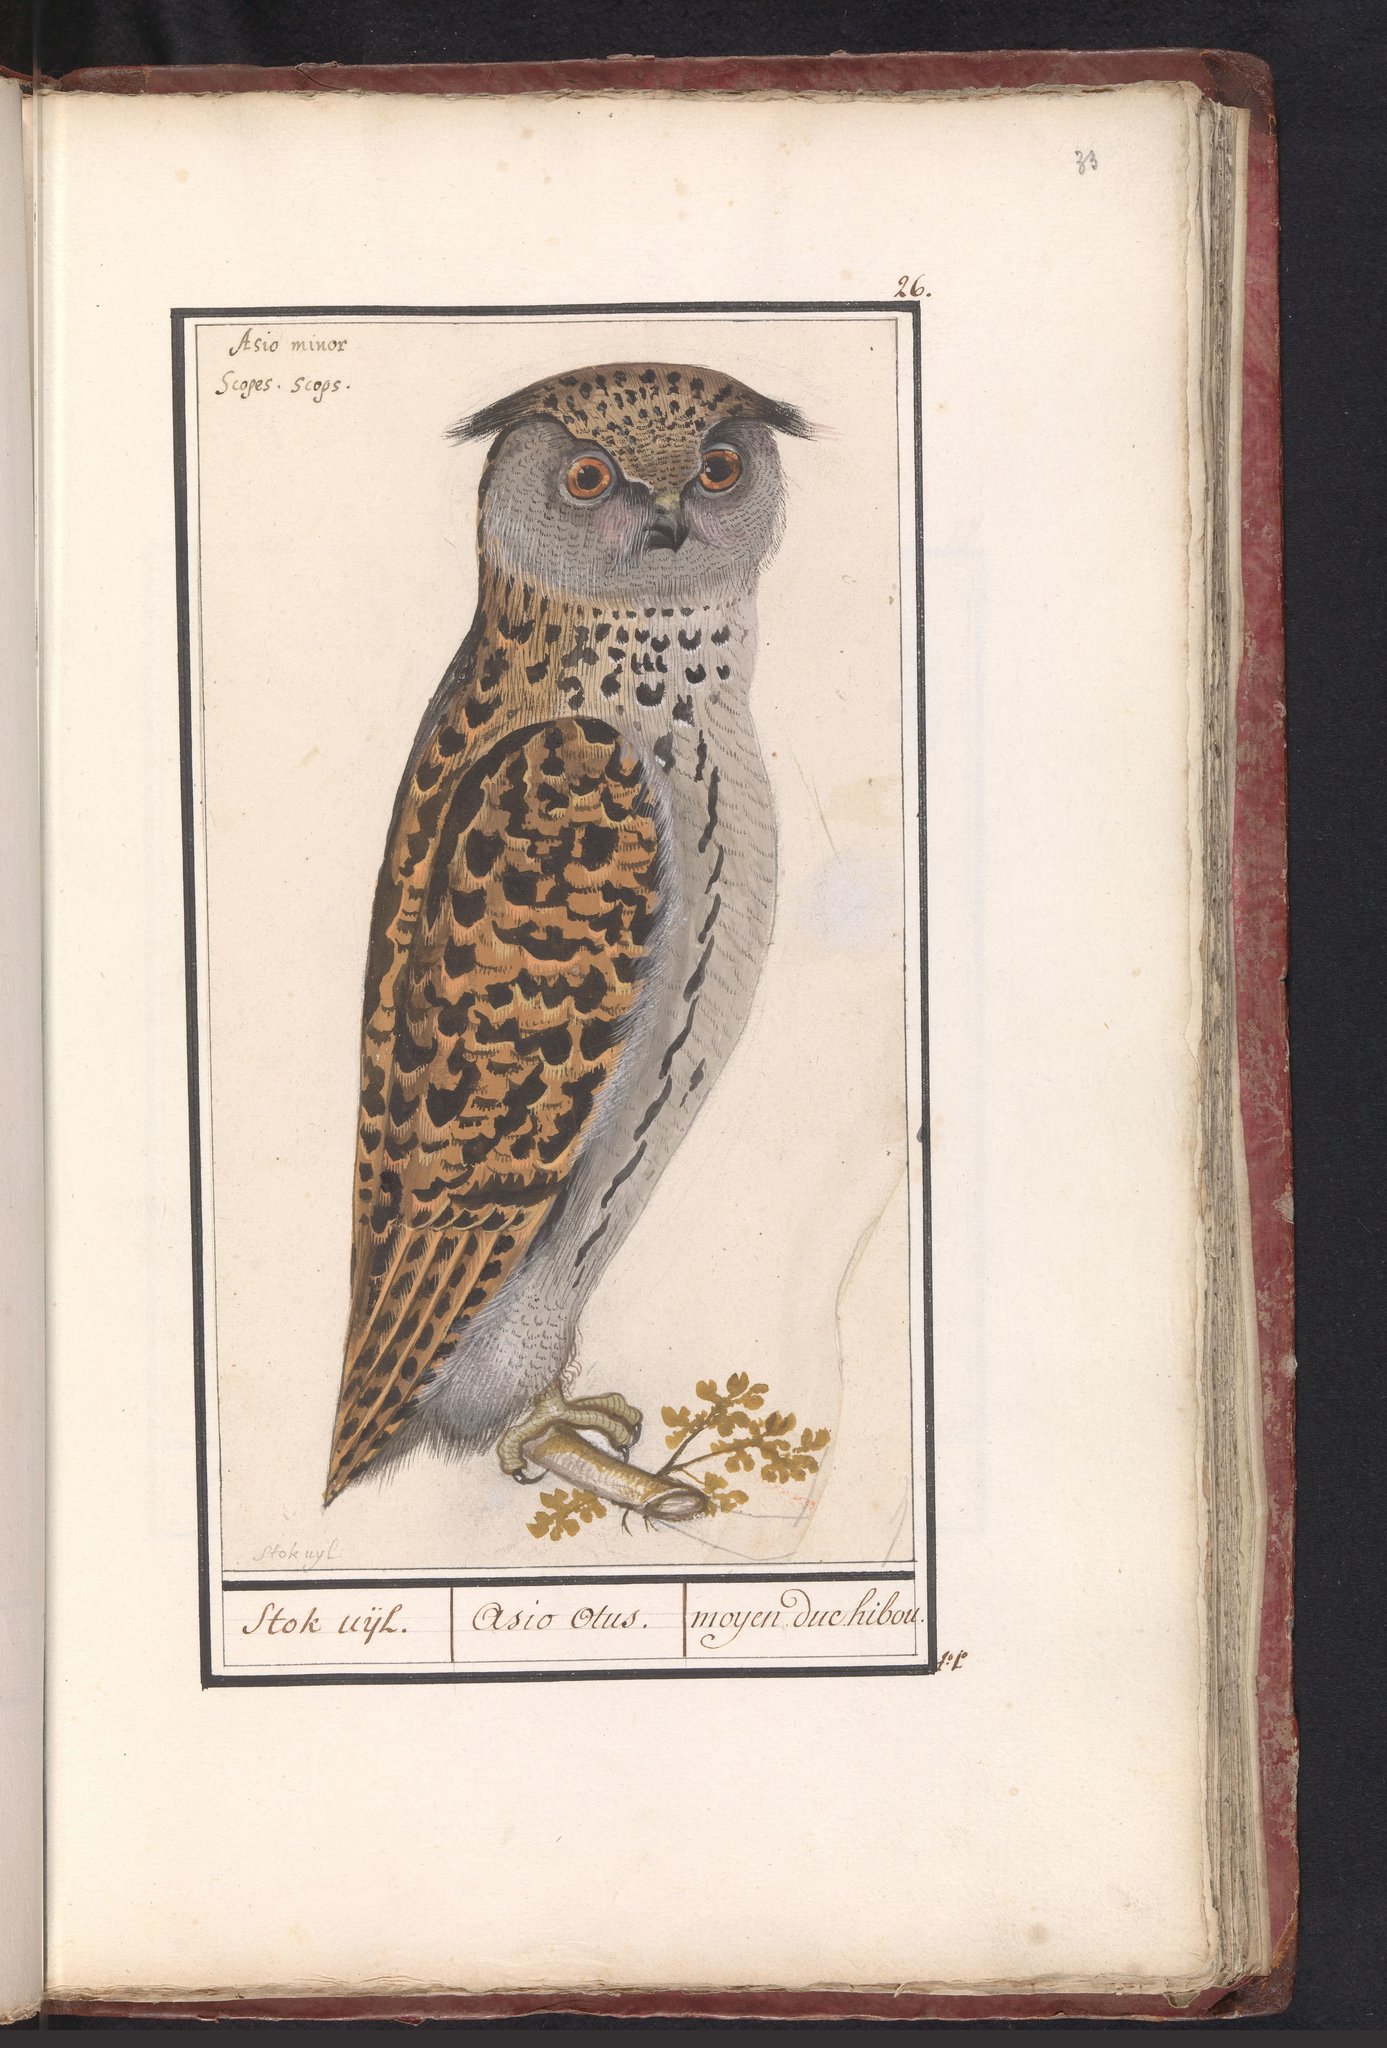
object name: drawing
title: European Scops-Owl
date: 1596-1610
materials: paint, ink, paper, pencil, watercolor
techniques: brush, pen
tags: owls: european scops-owl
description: De Boodt could study many live animals from faraway places in the menagerie (zoo) of Rudolf II in Prague. Moreover, stuffed animals could be found in the emperor’s famous Kunstkammer. Yet many drawings in the albums were not made from direct observation of nature, but were ‘borrowed’ from illustrations by other artists. Could the artist of this Scops-Owl have been looking at a live or stuffed specimen? Or did he copy it from another work of art?